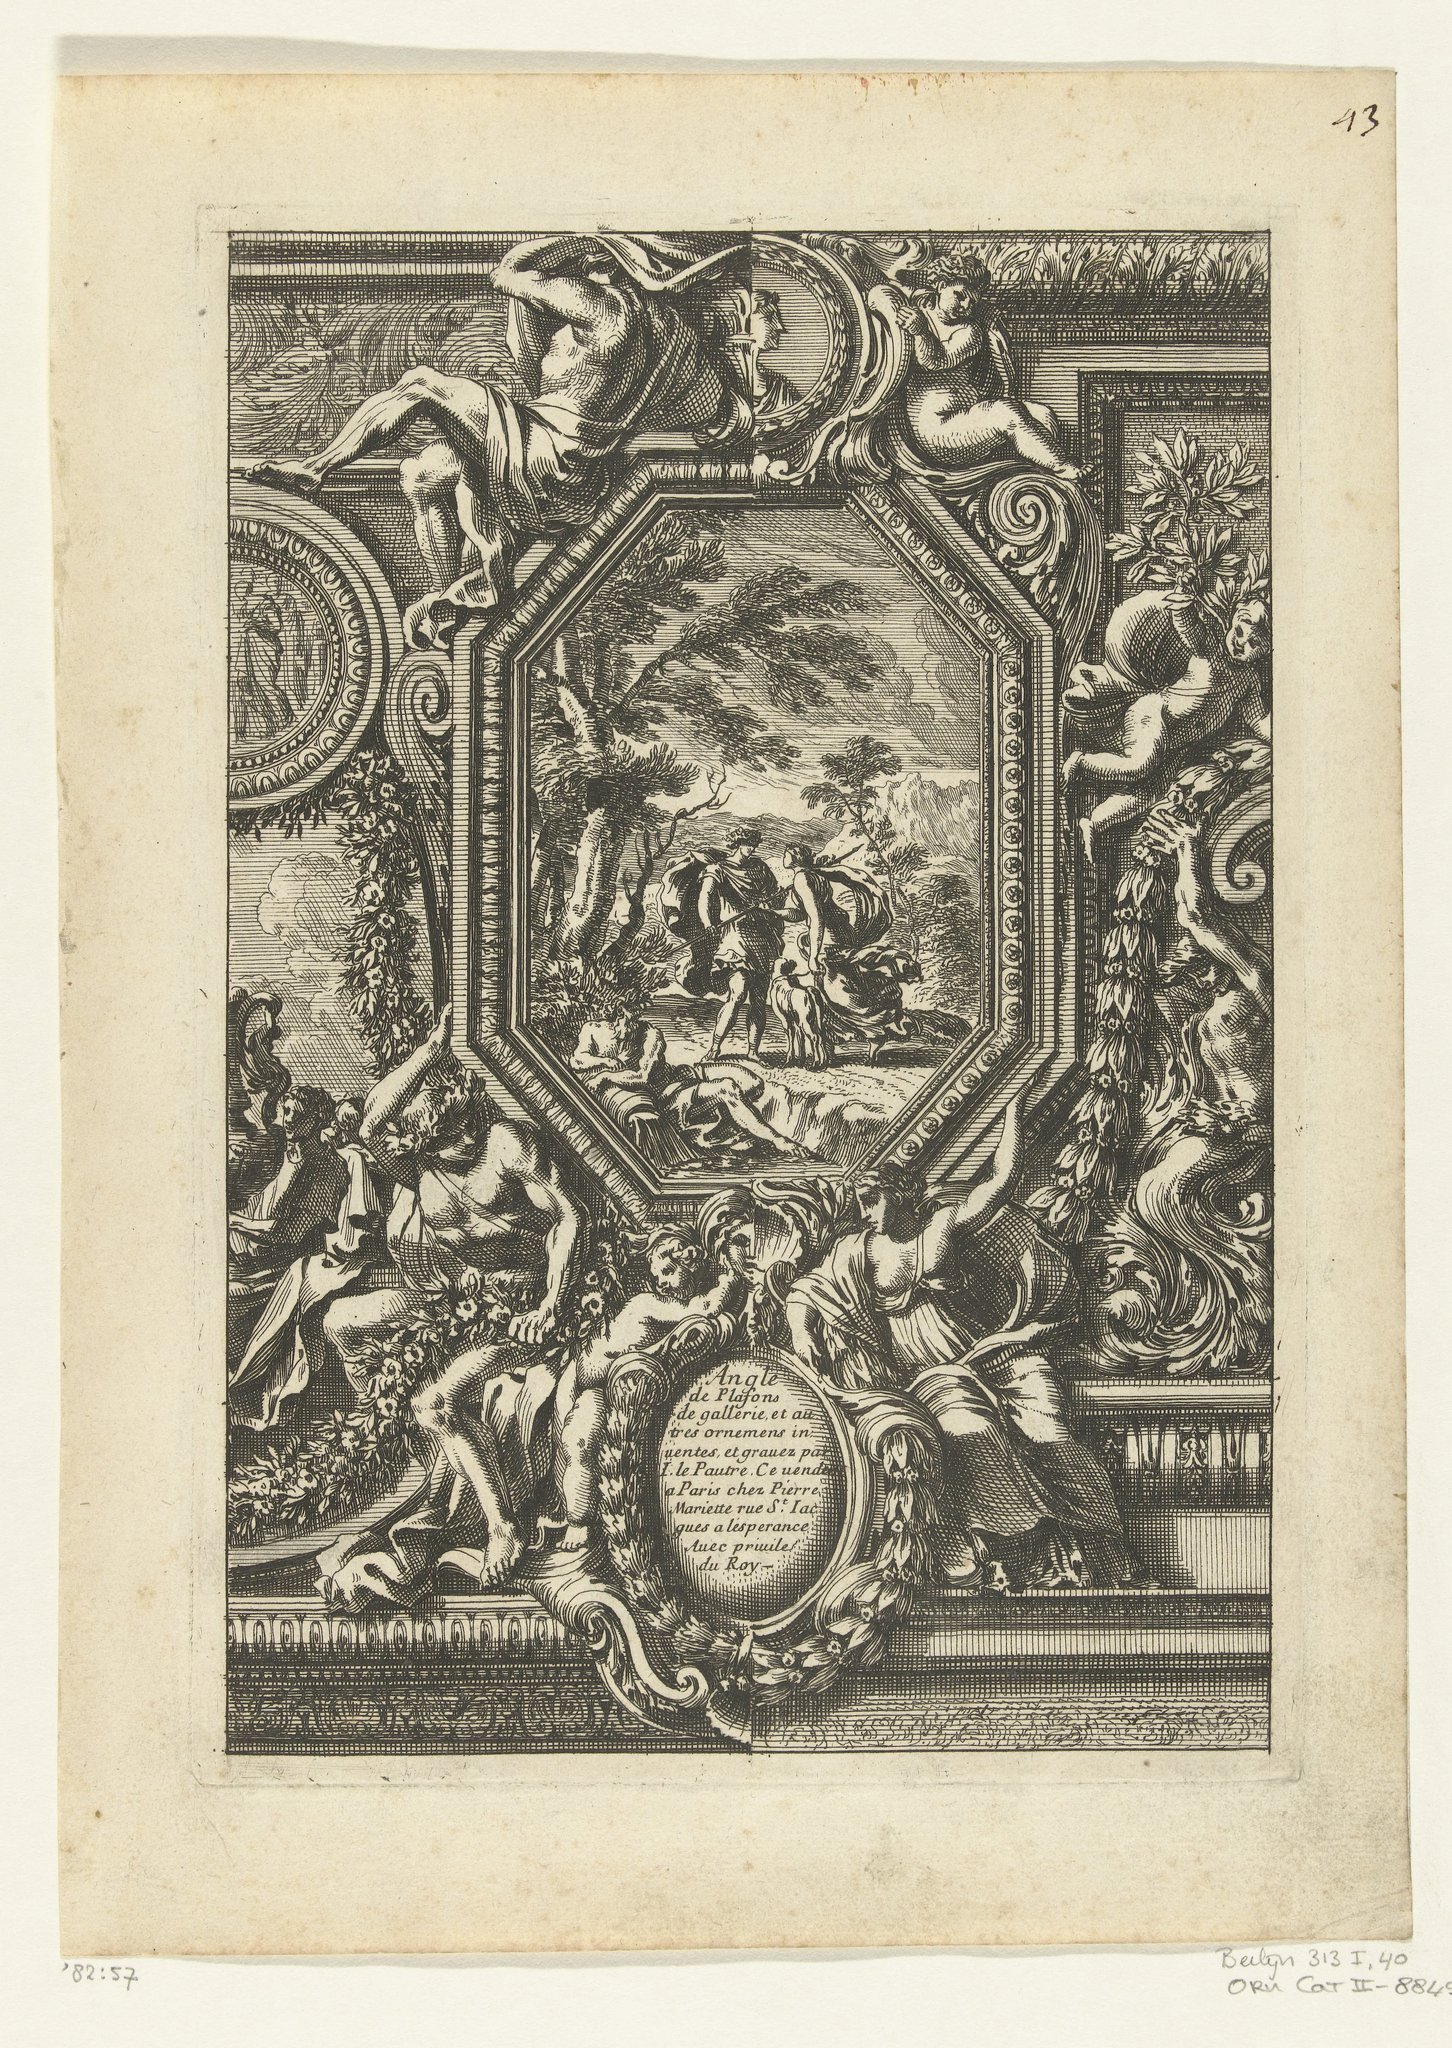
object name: titelblad, titelpagina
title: Angle de Plafons de gallerie, et autres ornemens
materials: paper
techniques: etching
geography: france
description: Ontwerp voor hoekdecoratie van een plafond met een variant voor de rechterhelft en in het midden een verticaal achthoekig paneel met Cephalus en Procris in een landschap. Uit serie van 6 ongenummerde bladen.